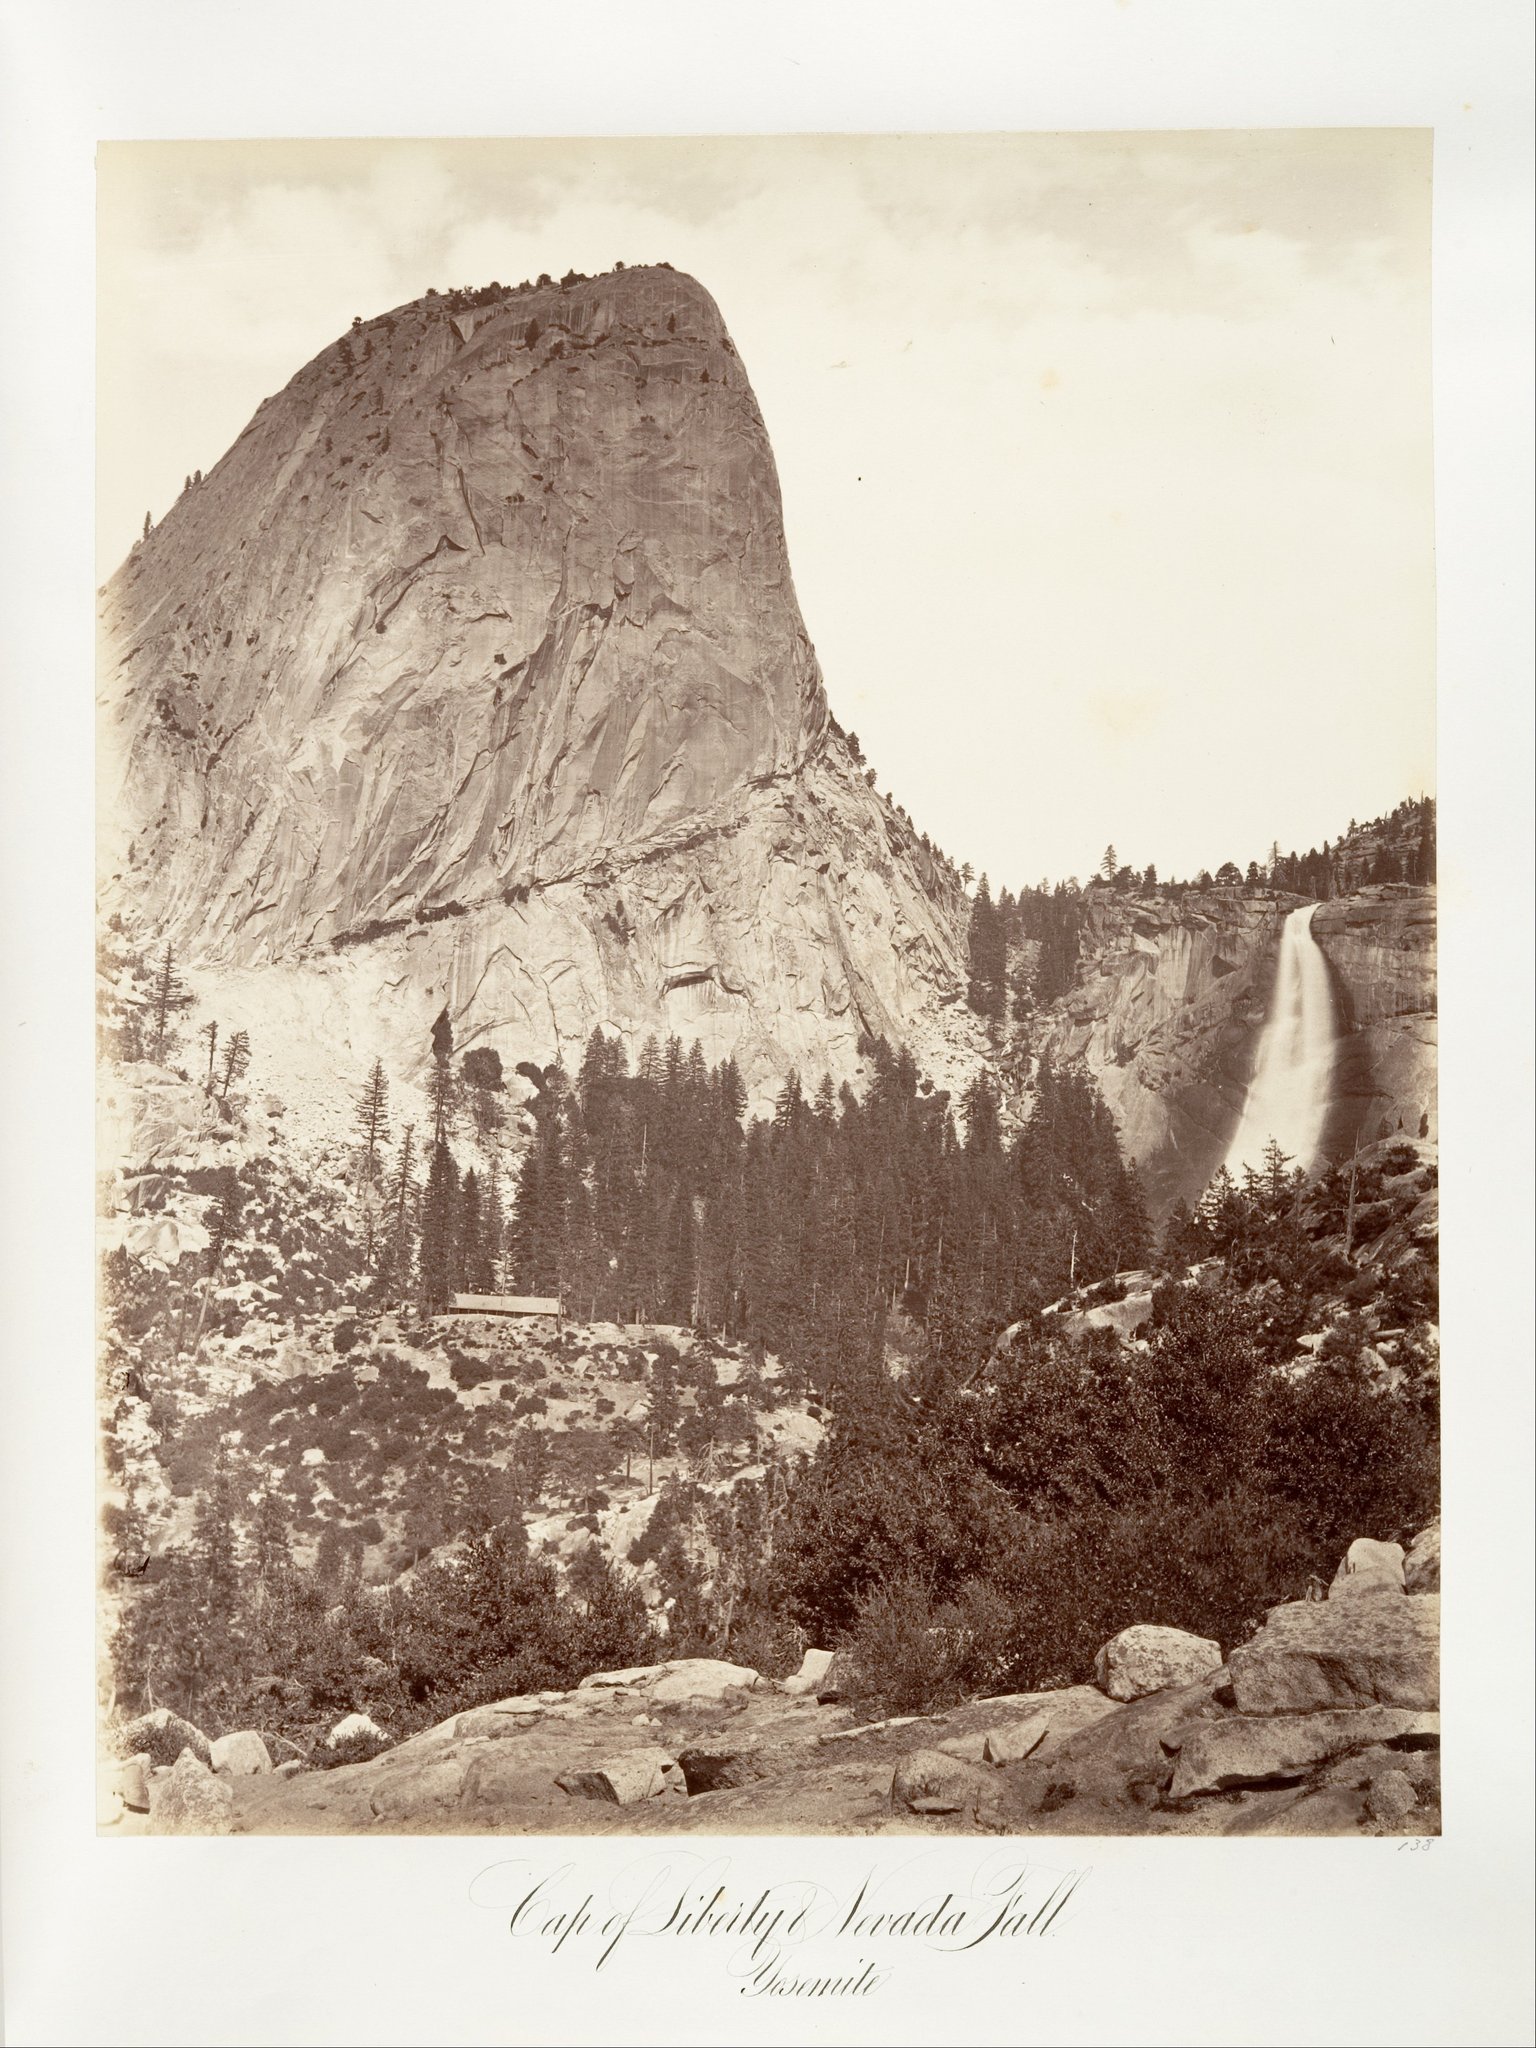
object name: photograph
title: Cap of Liberty and Nevada Fall, Yosemite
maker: carleton e. watkins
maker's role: artist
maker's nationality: american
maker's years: 1829-1916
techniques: albumen silver print, glass negative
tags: waterfalls,mountains,landscapes